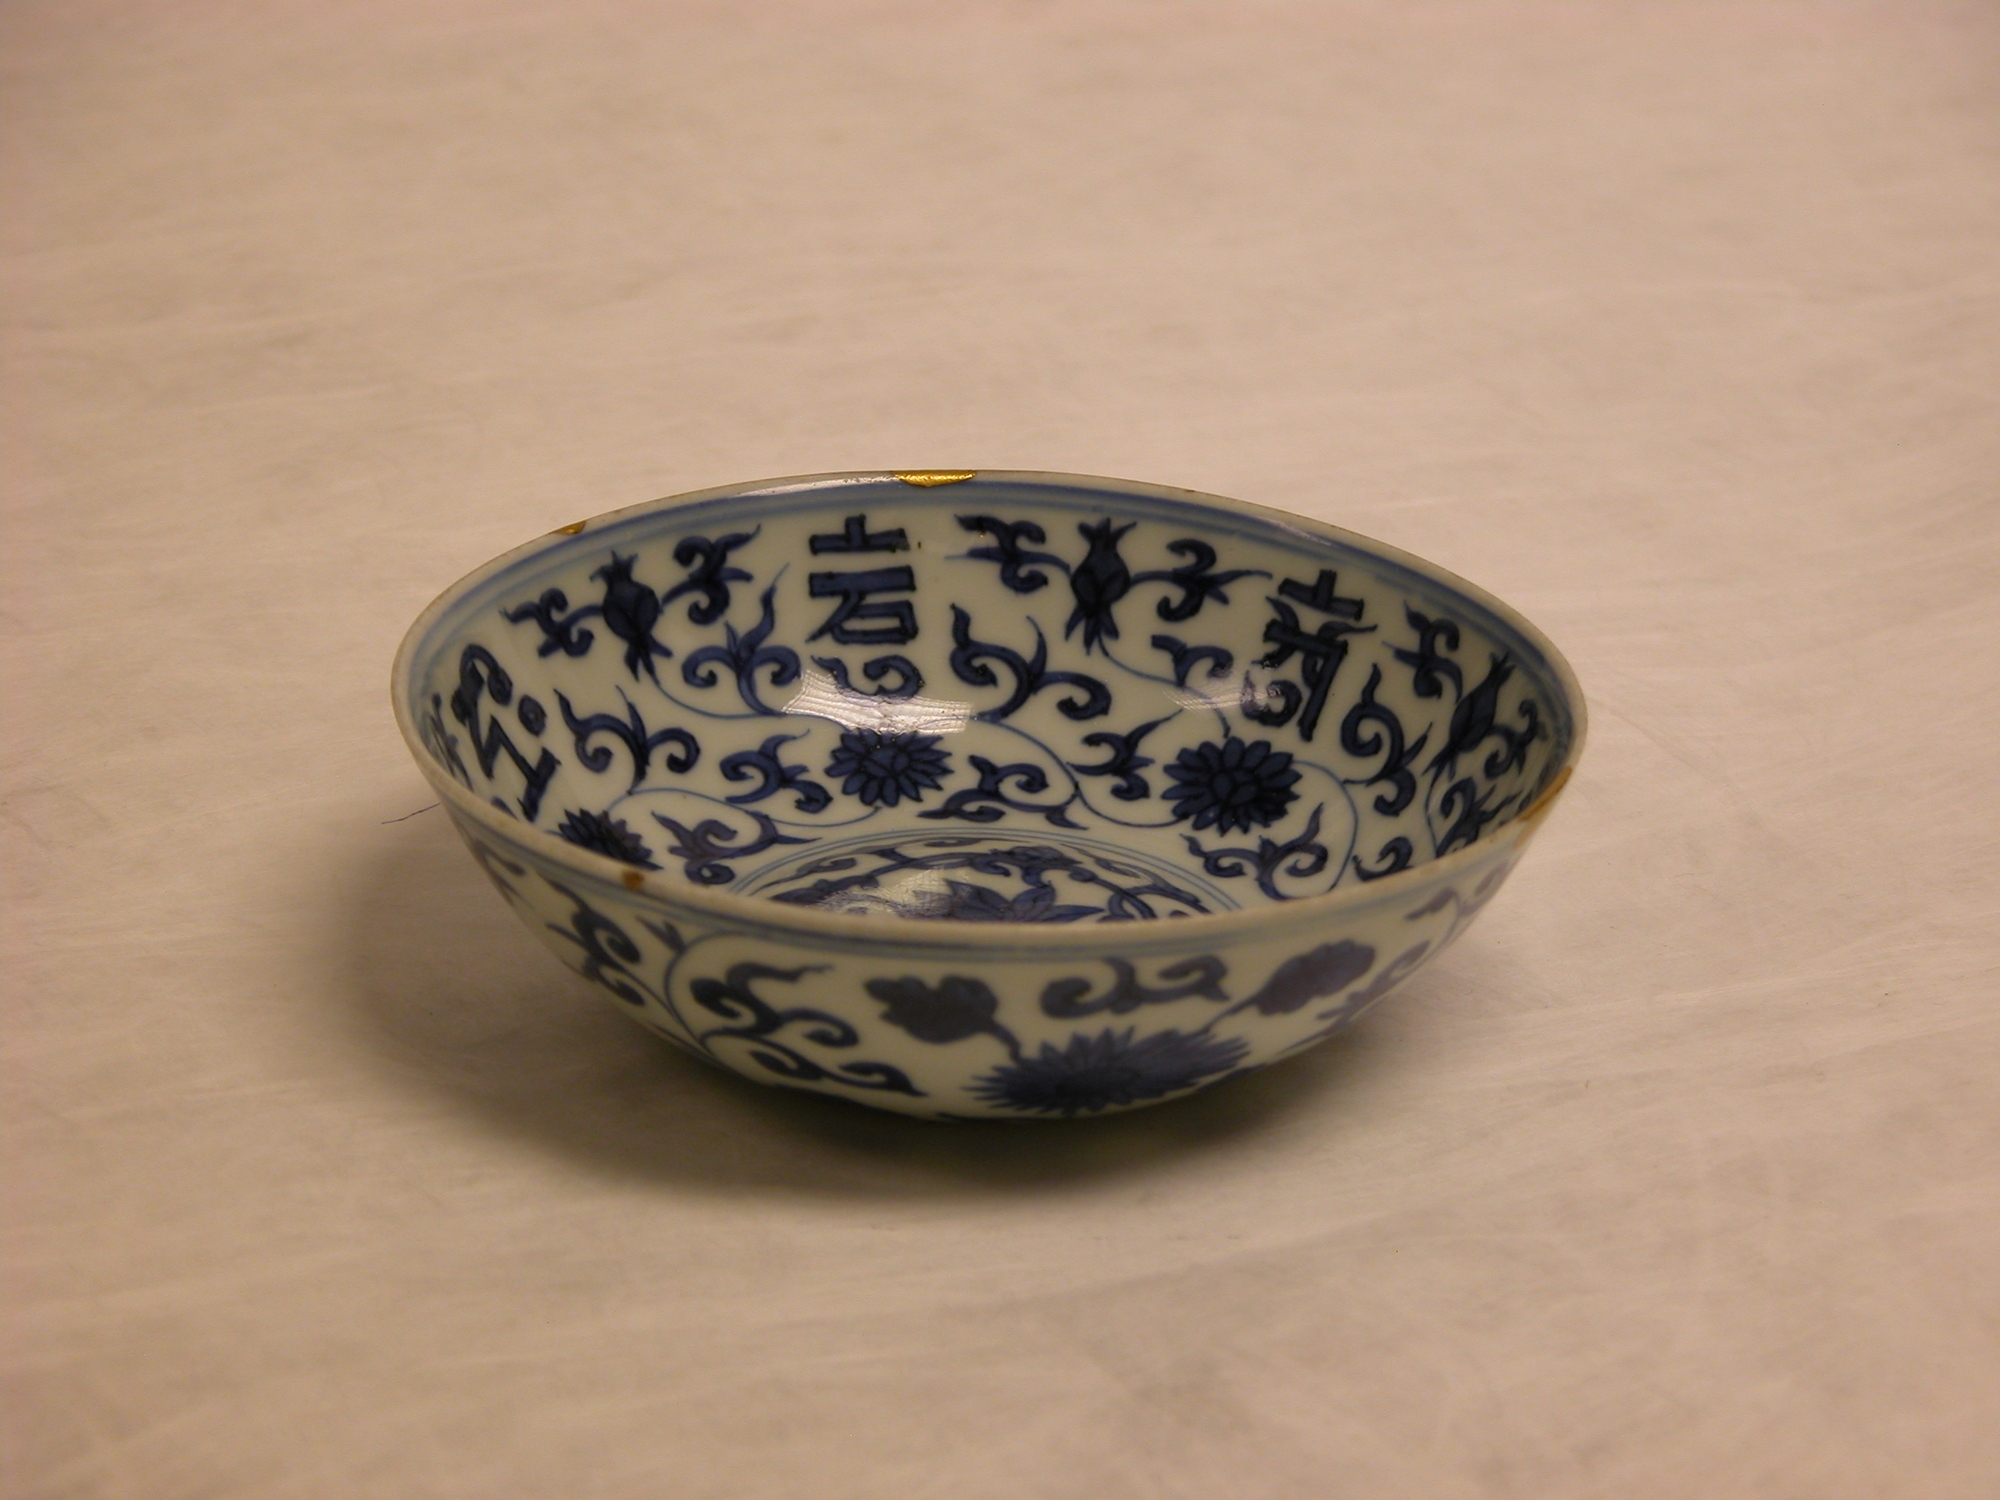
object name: saucer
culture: chinese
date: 1573-1620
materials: porcelain